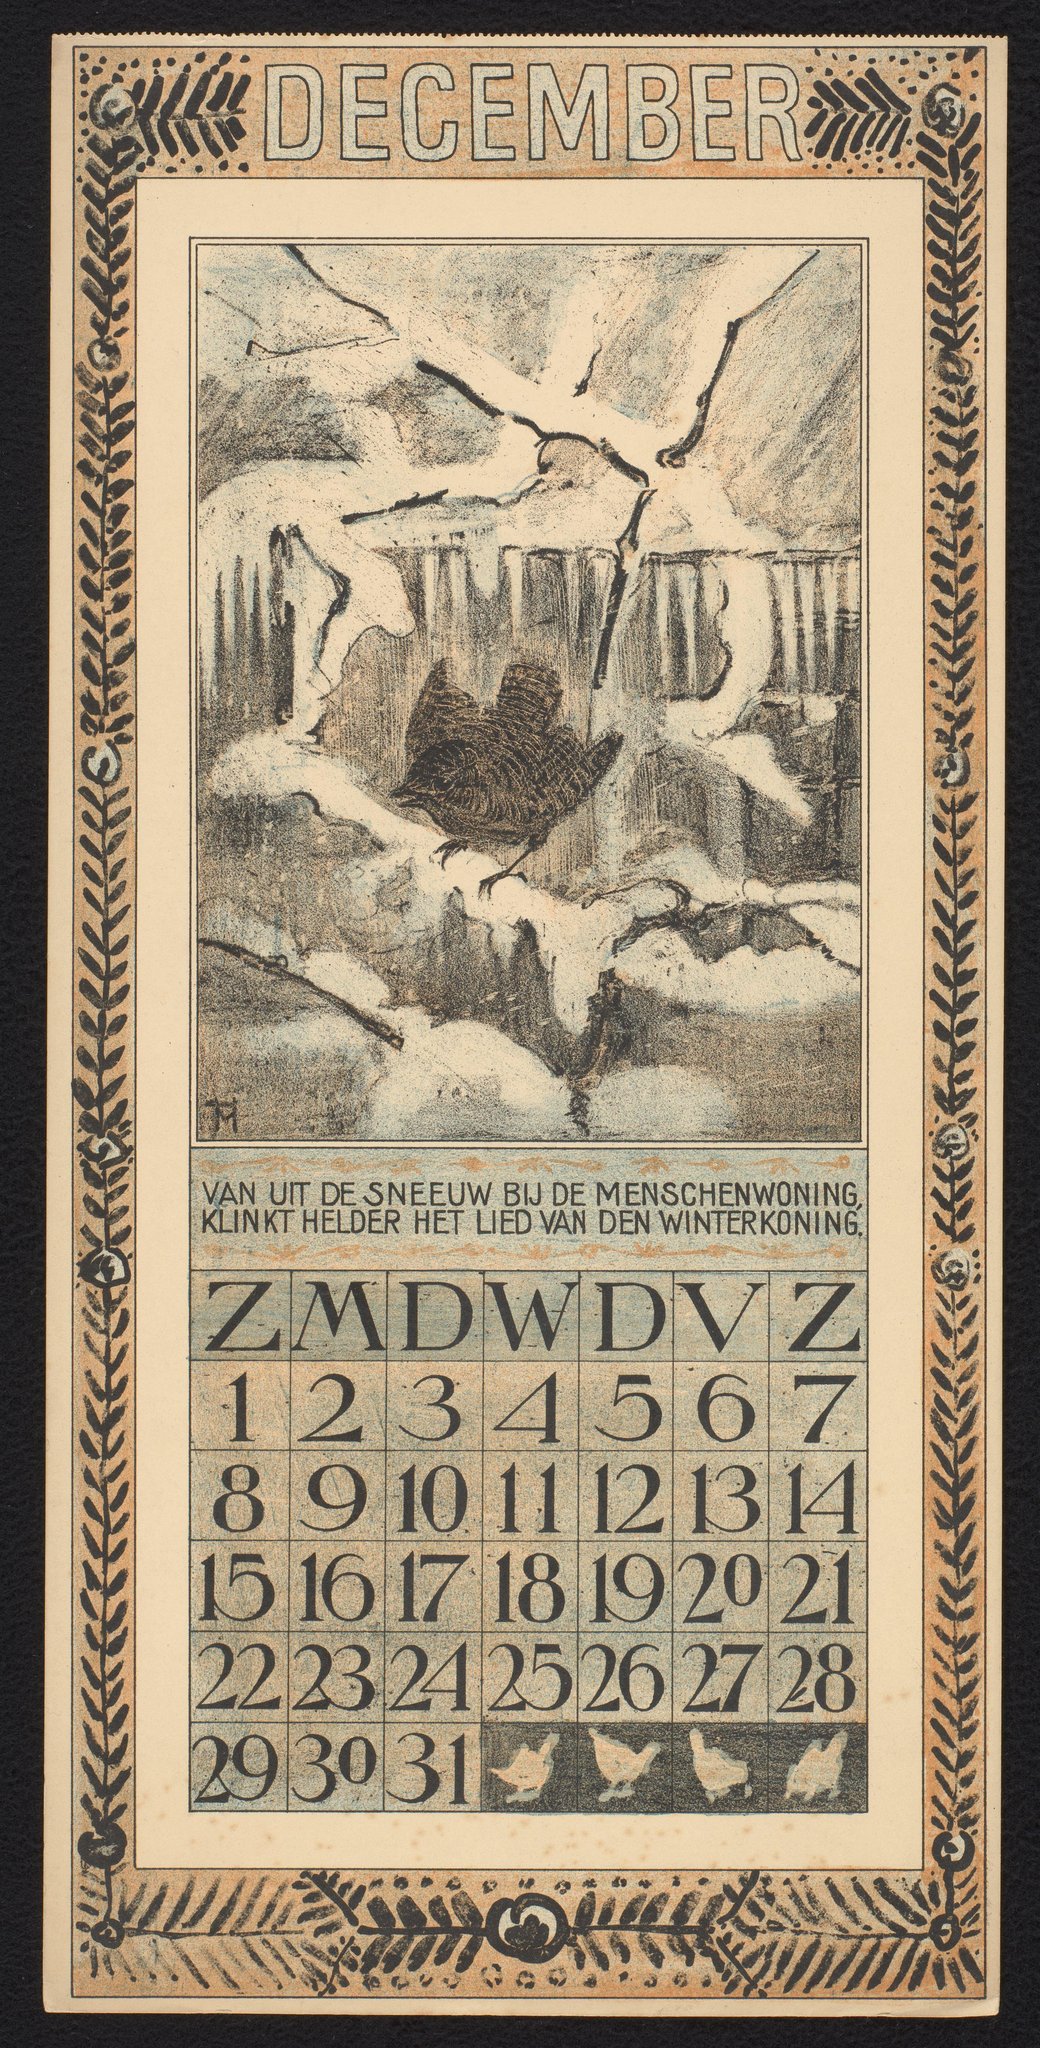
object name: print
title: Kalenderblad voor december 1907 met een winterkoning in de sneeuw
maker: theo van hoytema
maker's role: draughtsman, painter, print maker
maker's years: 1863-1917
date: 1906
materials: paper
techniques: lithograph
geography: amsterdam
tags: calendar, almanac, song-birds: wren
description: Onder de voorstelling de spreuk: 'Van uit de sneeuw bij de menschenwoning, klinkt helder het lied van den winterkoning'.